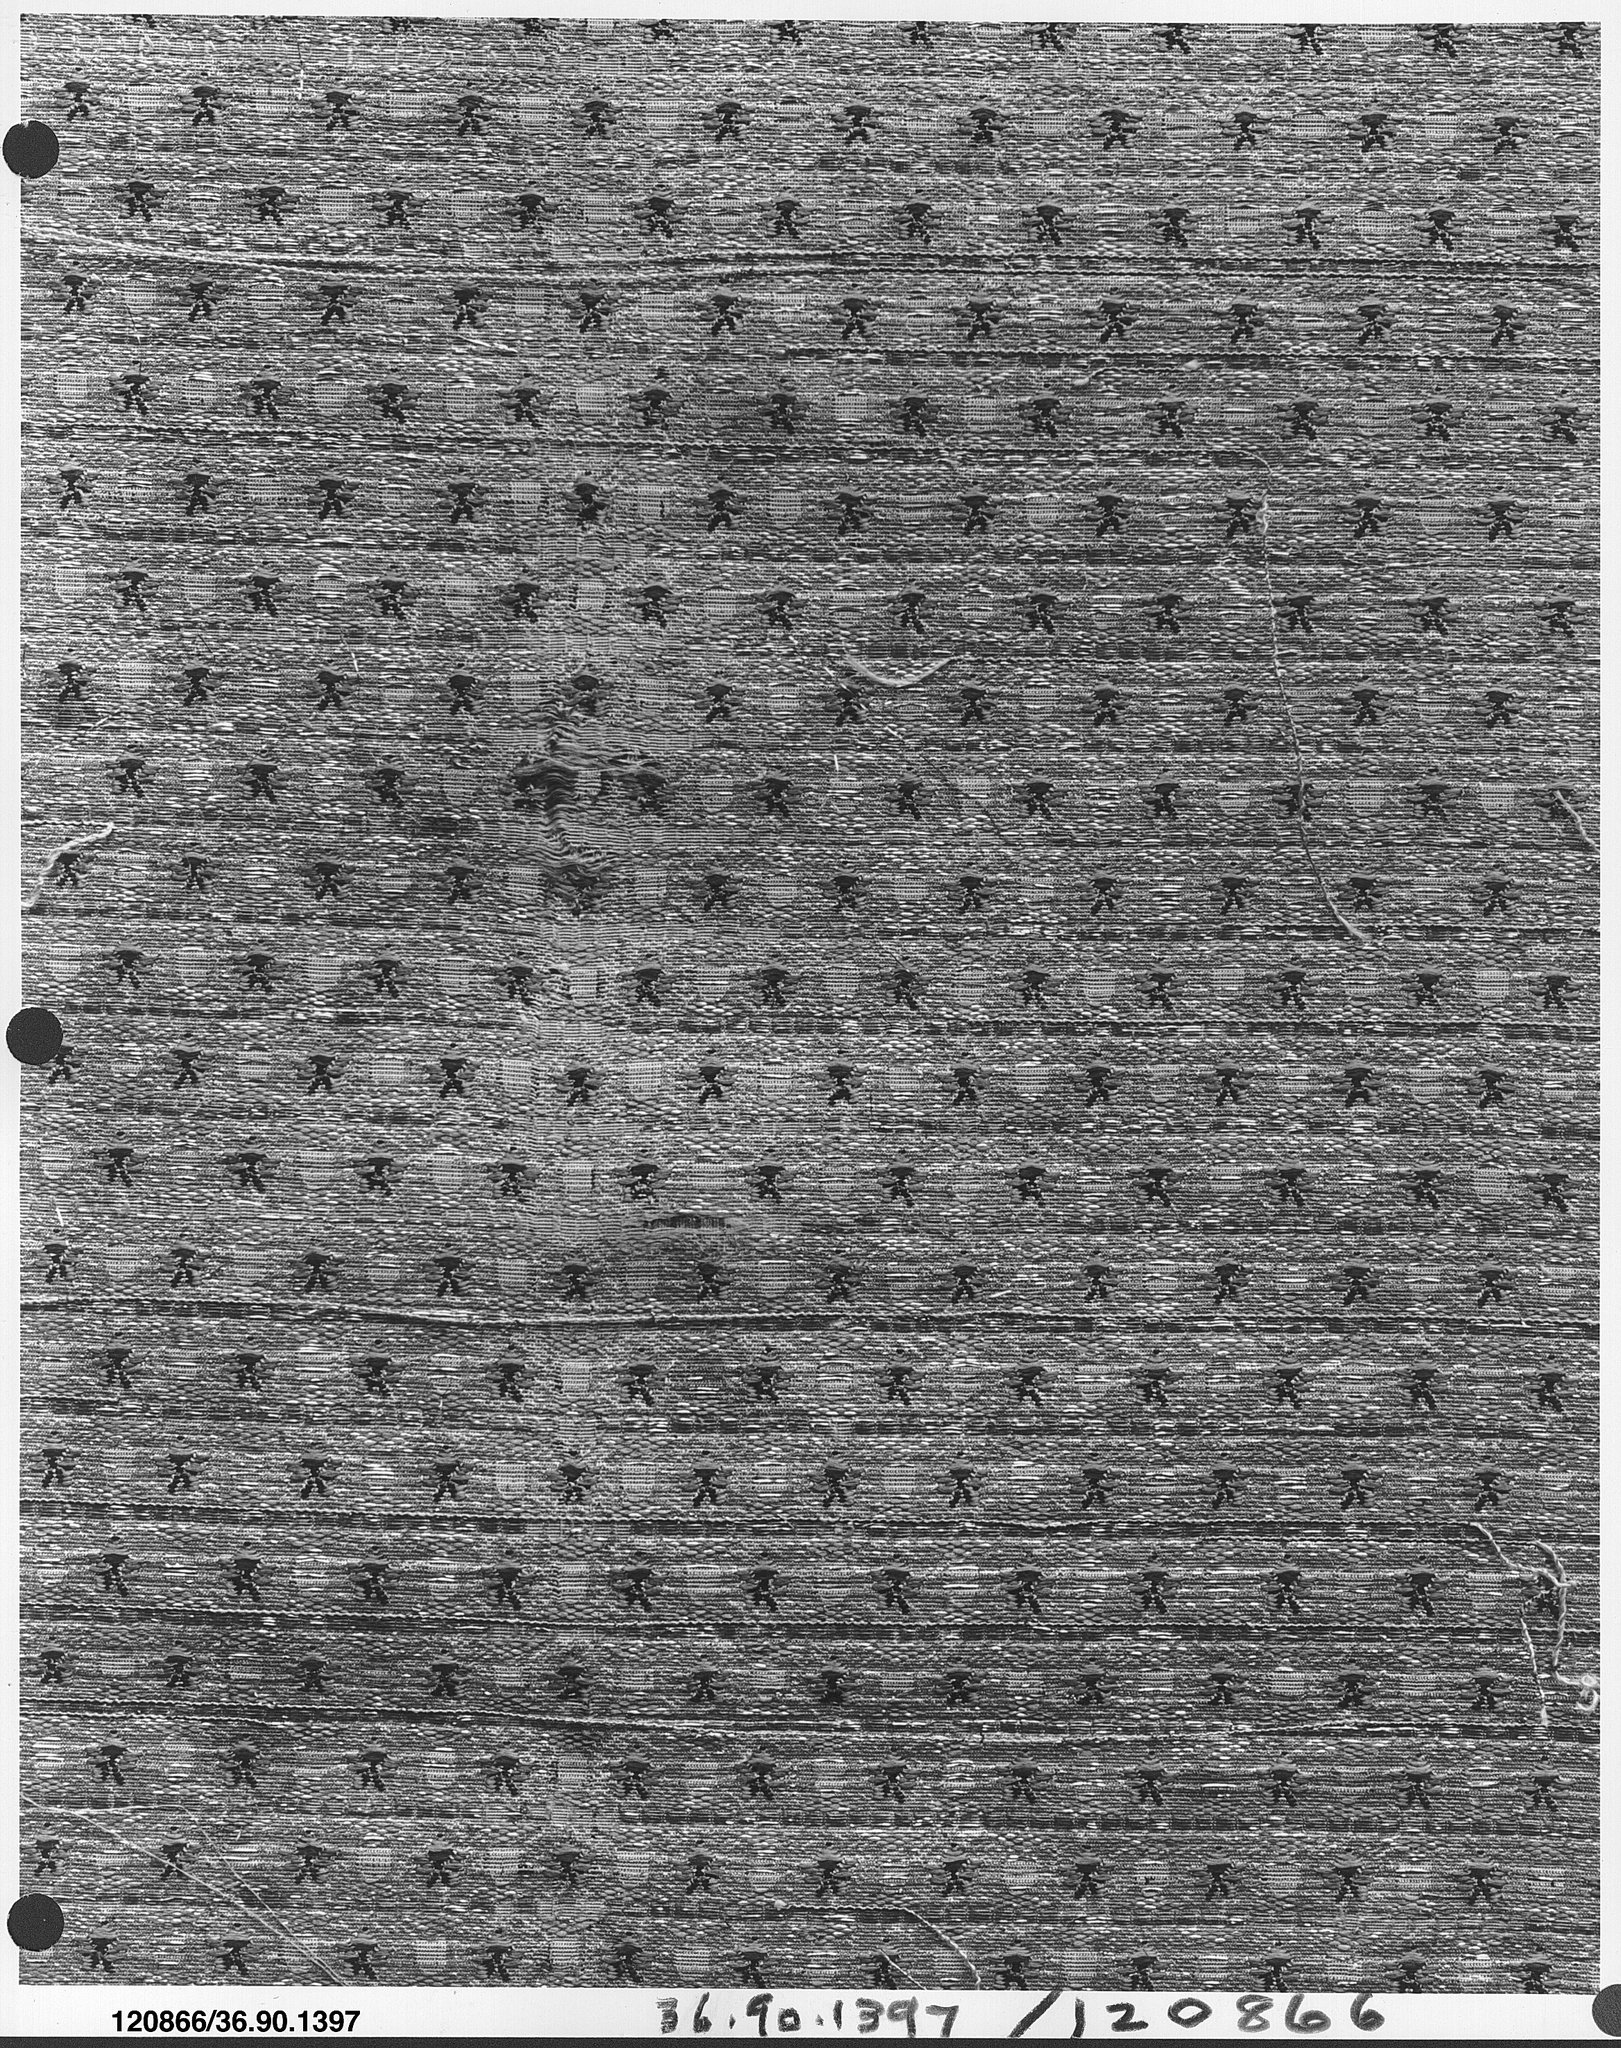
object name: piece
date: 1701-1800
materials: metal thread, silk